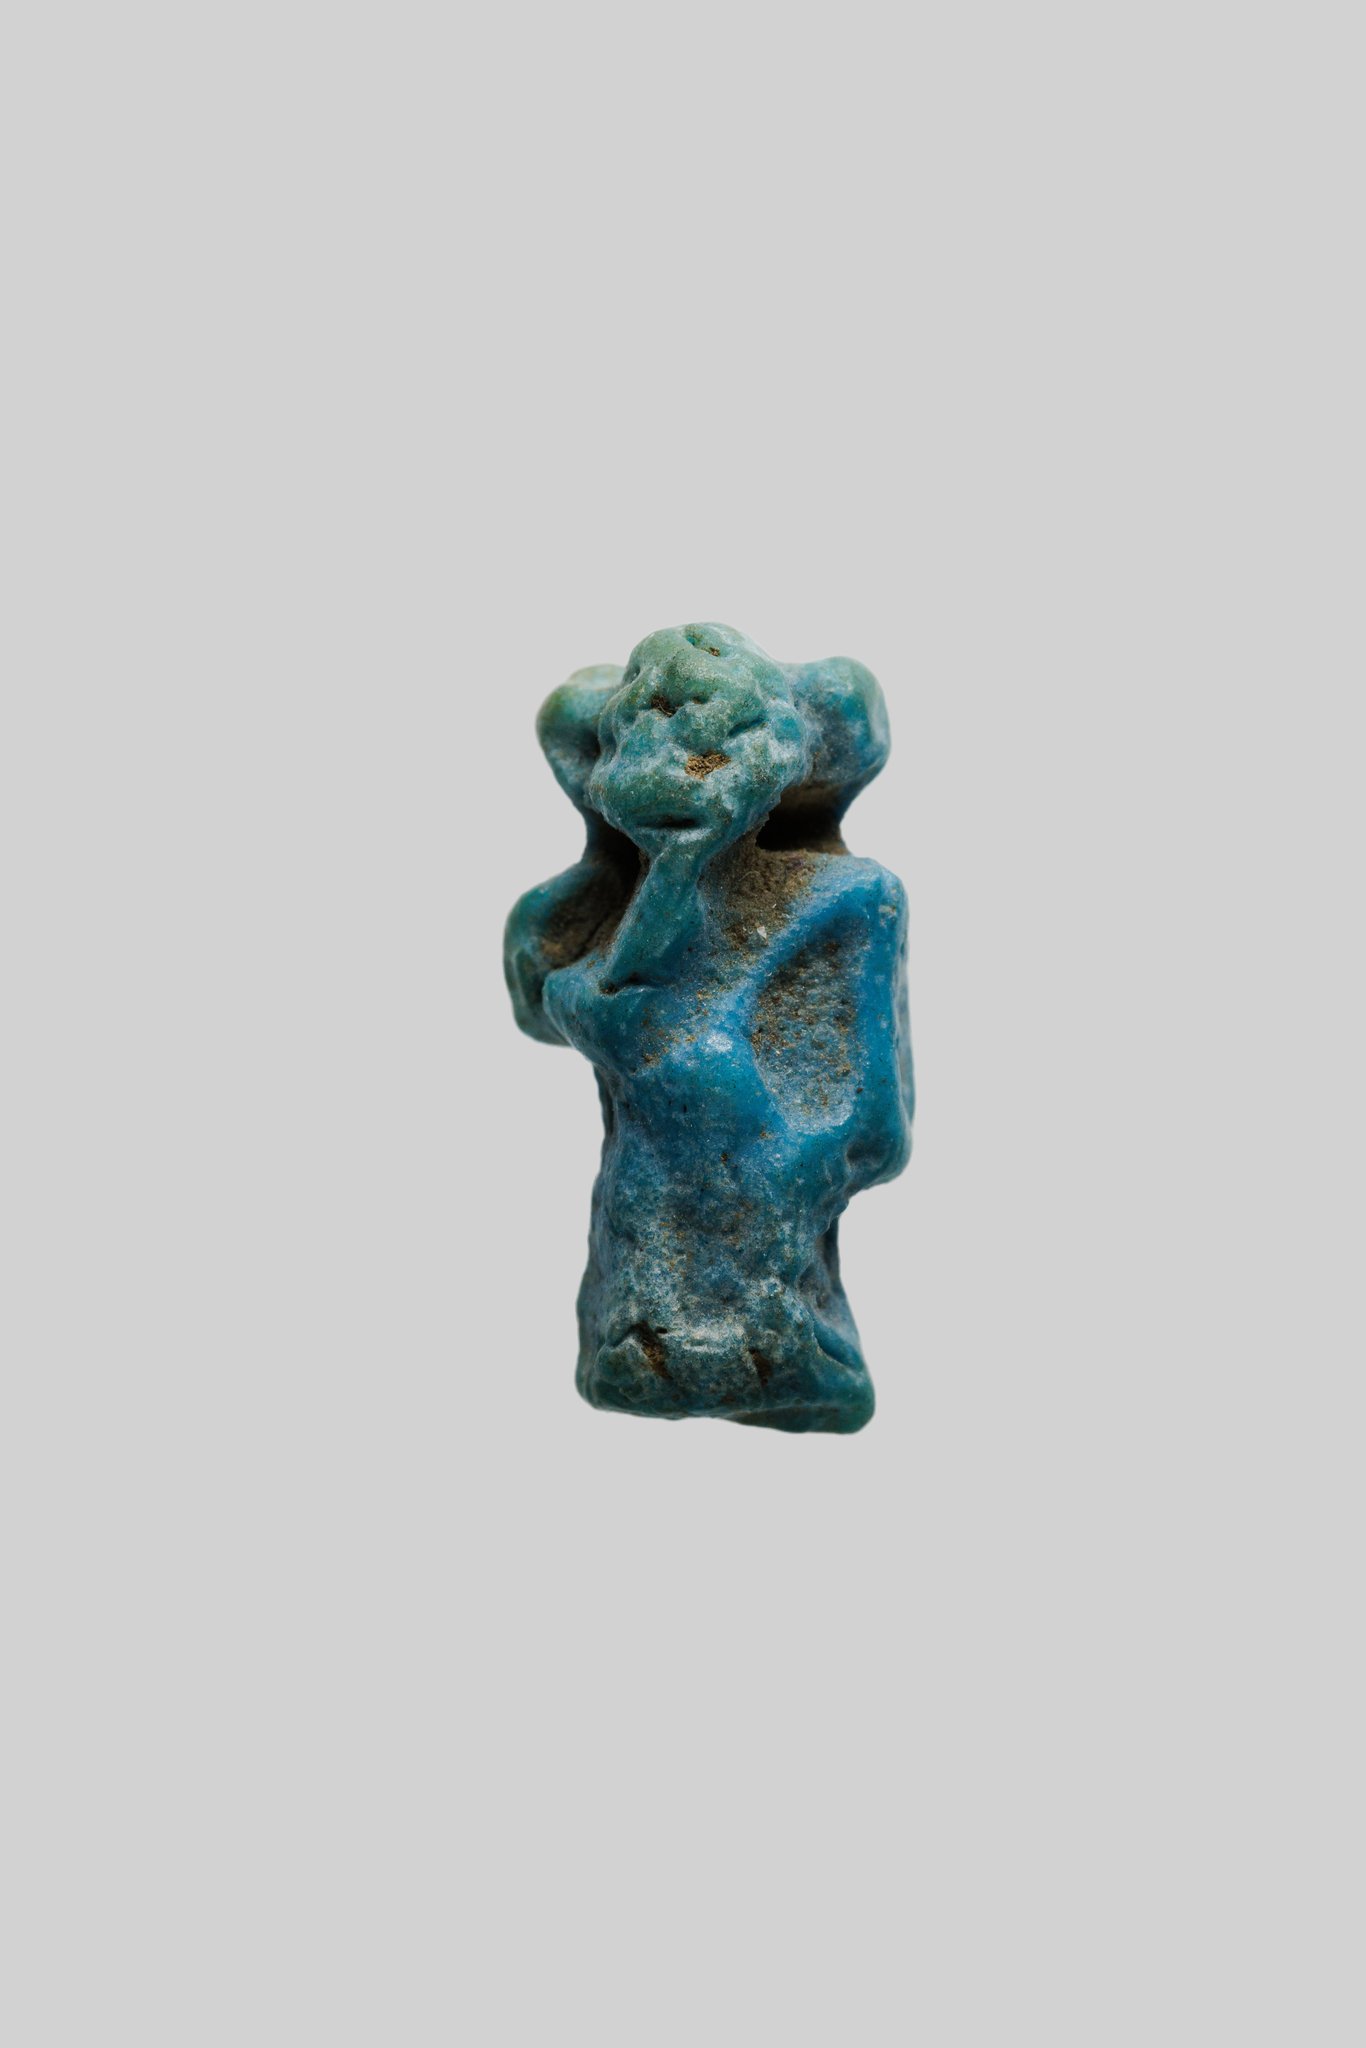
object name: amulet, harpokrates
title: Harpokrates amulet (?)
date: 1295-1070 BCE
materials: faience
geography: egypt